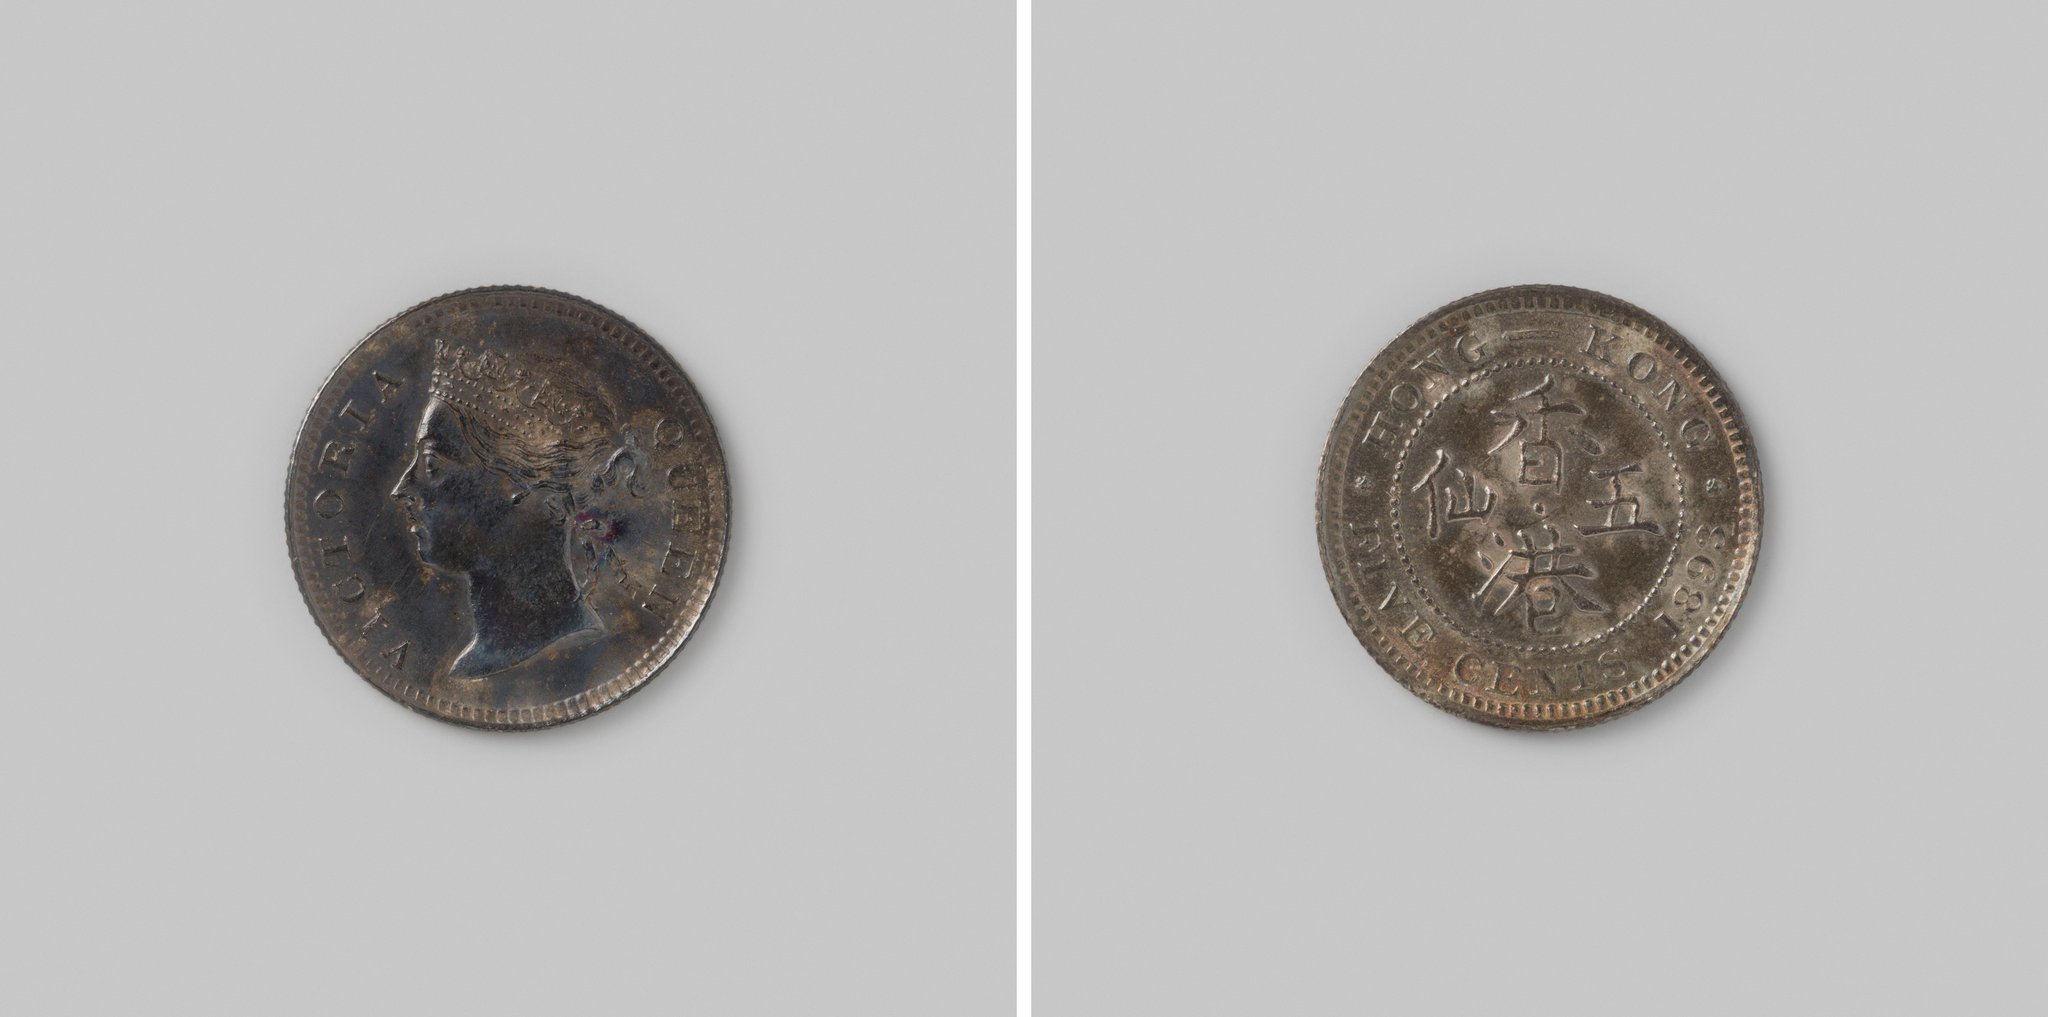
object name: coin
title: 5 cents uit Hongkong van koningin Victoria, 1893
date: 1893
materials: silver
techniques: striking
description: Zilveren munt. Voorzijde: hoofd van de koningin met diadeem naar links. Daaronder letter H [=Heaton-mint te Birmingham]. Keerzijde: in het omschrift waarde-aanduiding: 5 cents met rechts daarvan jaartal. Kartelrand.